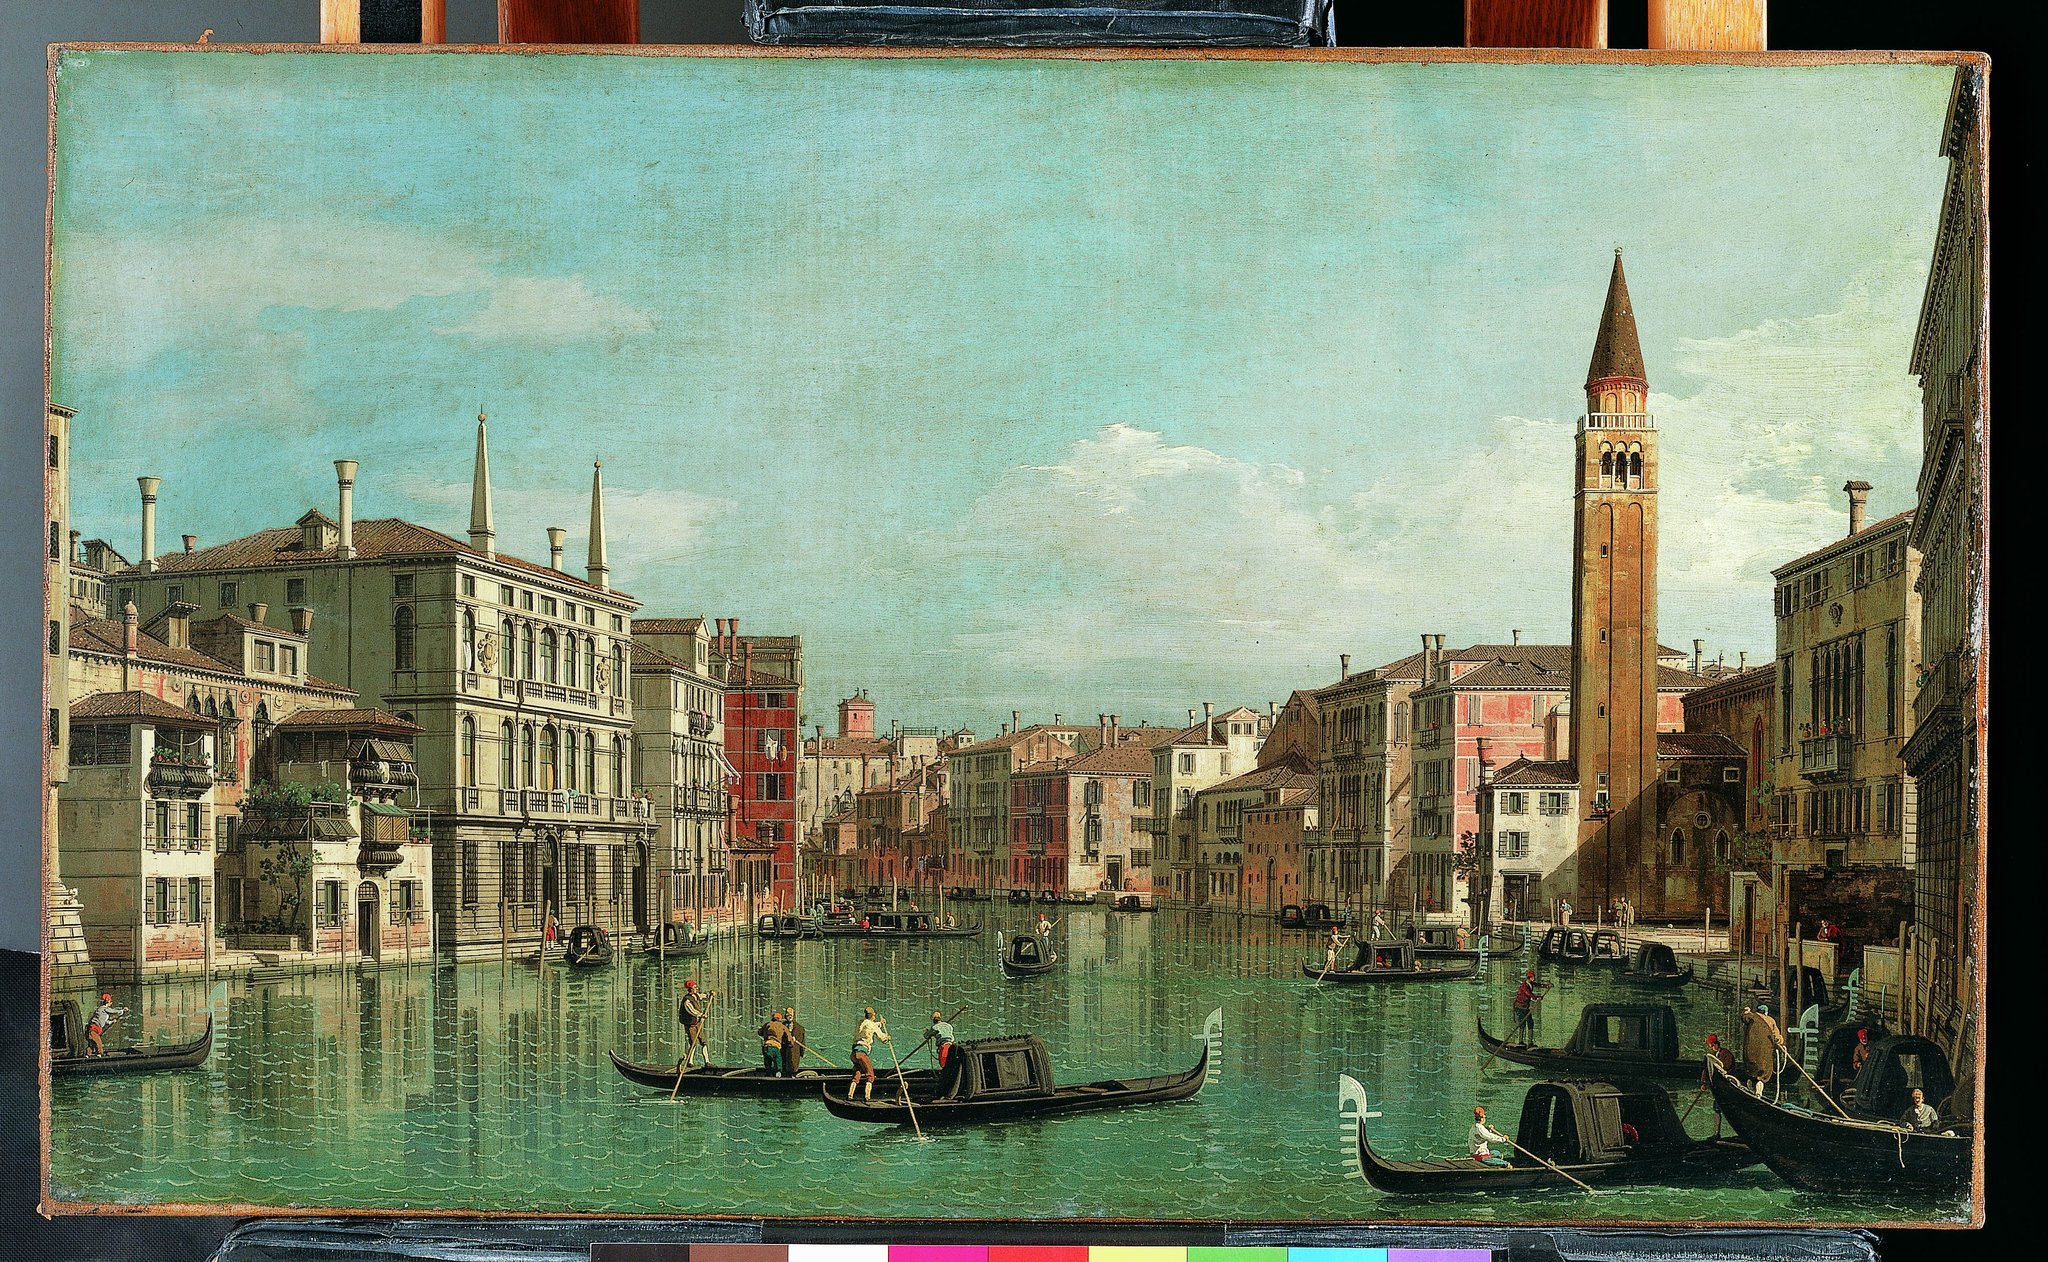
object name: painting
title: The Grand Canal, Venice, Looking Southeast, with the Campo della Carità to the Right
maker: canaletto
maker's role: artist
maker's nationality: italian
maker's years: 1697-1768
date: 1730-1739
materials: canvas, oil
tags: towers,canals,boats,venice